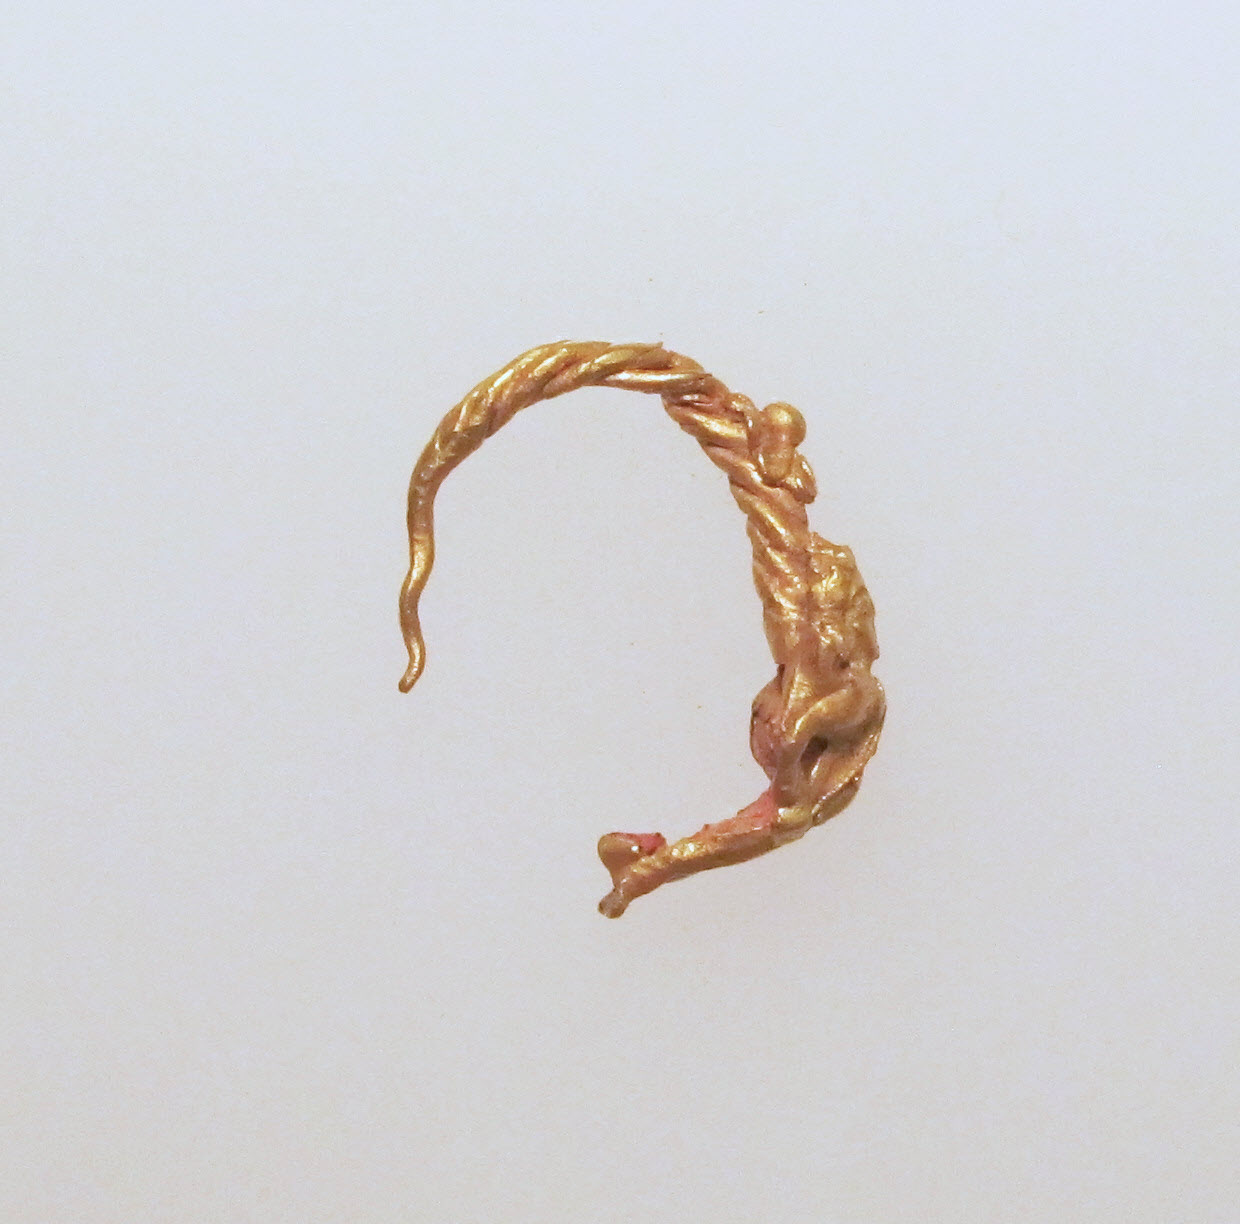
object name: earring with human figure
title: Gold earring with figure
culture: greek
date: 300-101 BCE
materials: gold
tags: human figures